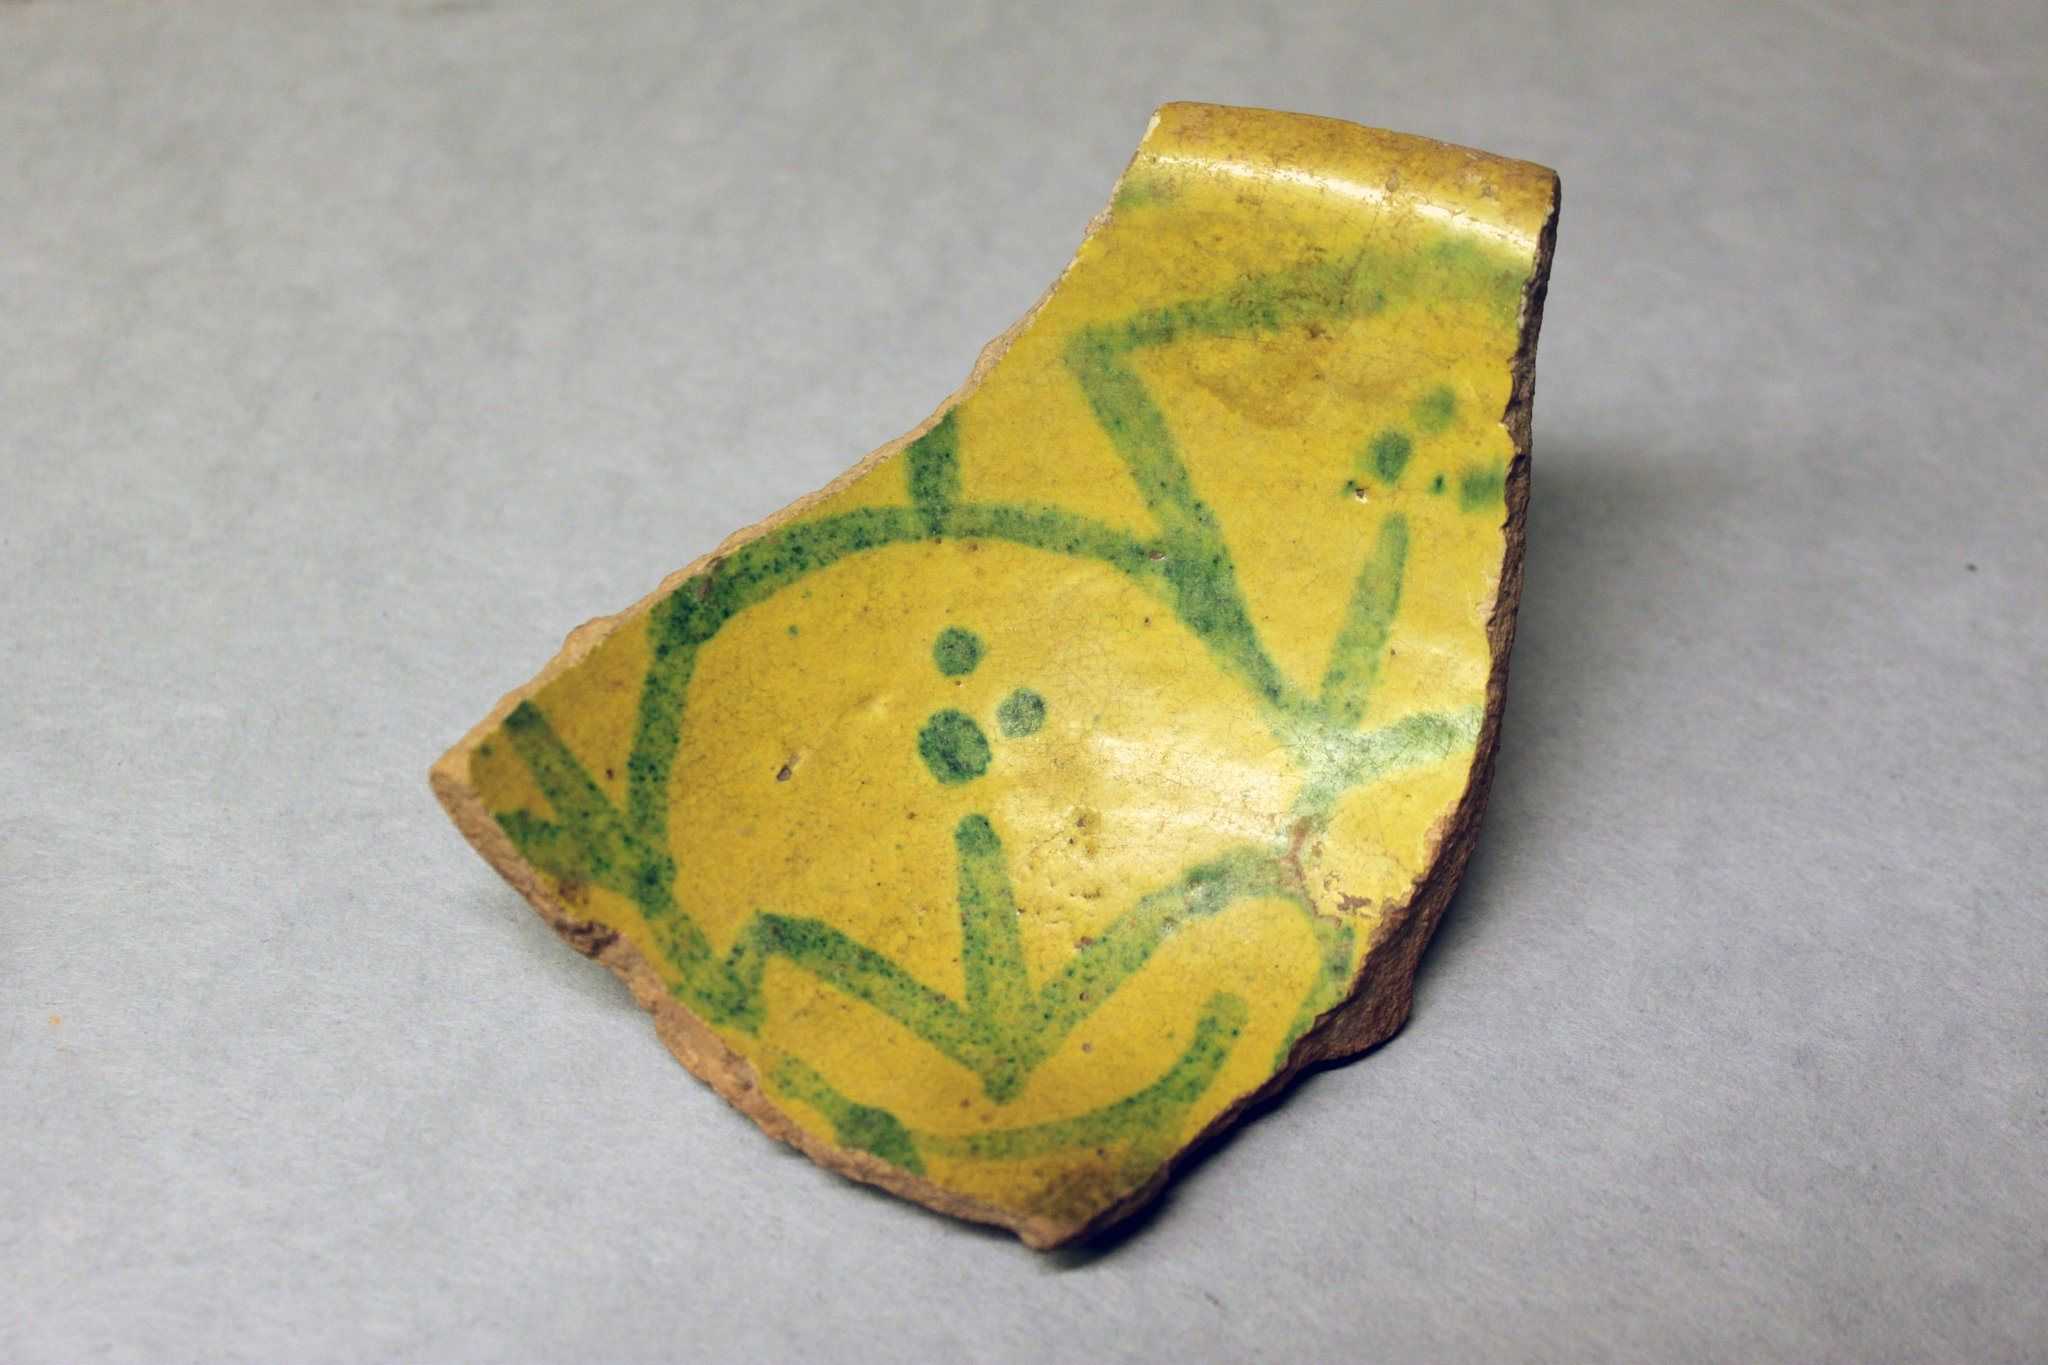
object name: fragment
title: Fragment of a Bowl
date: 801-900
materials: earthenware, glaze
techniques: glazing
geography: iran